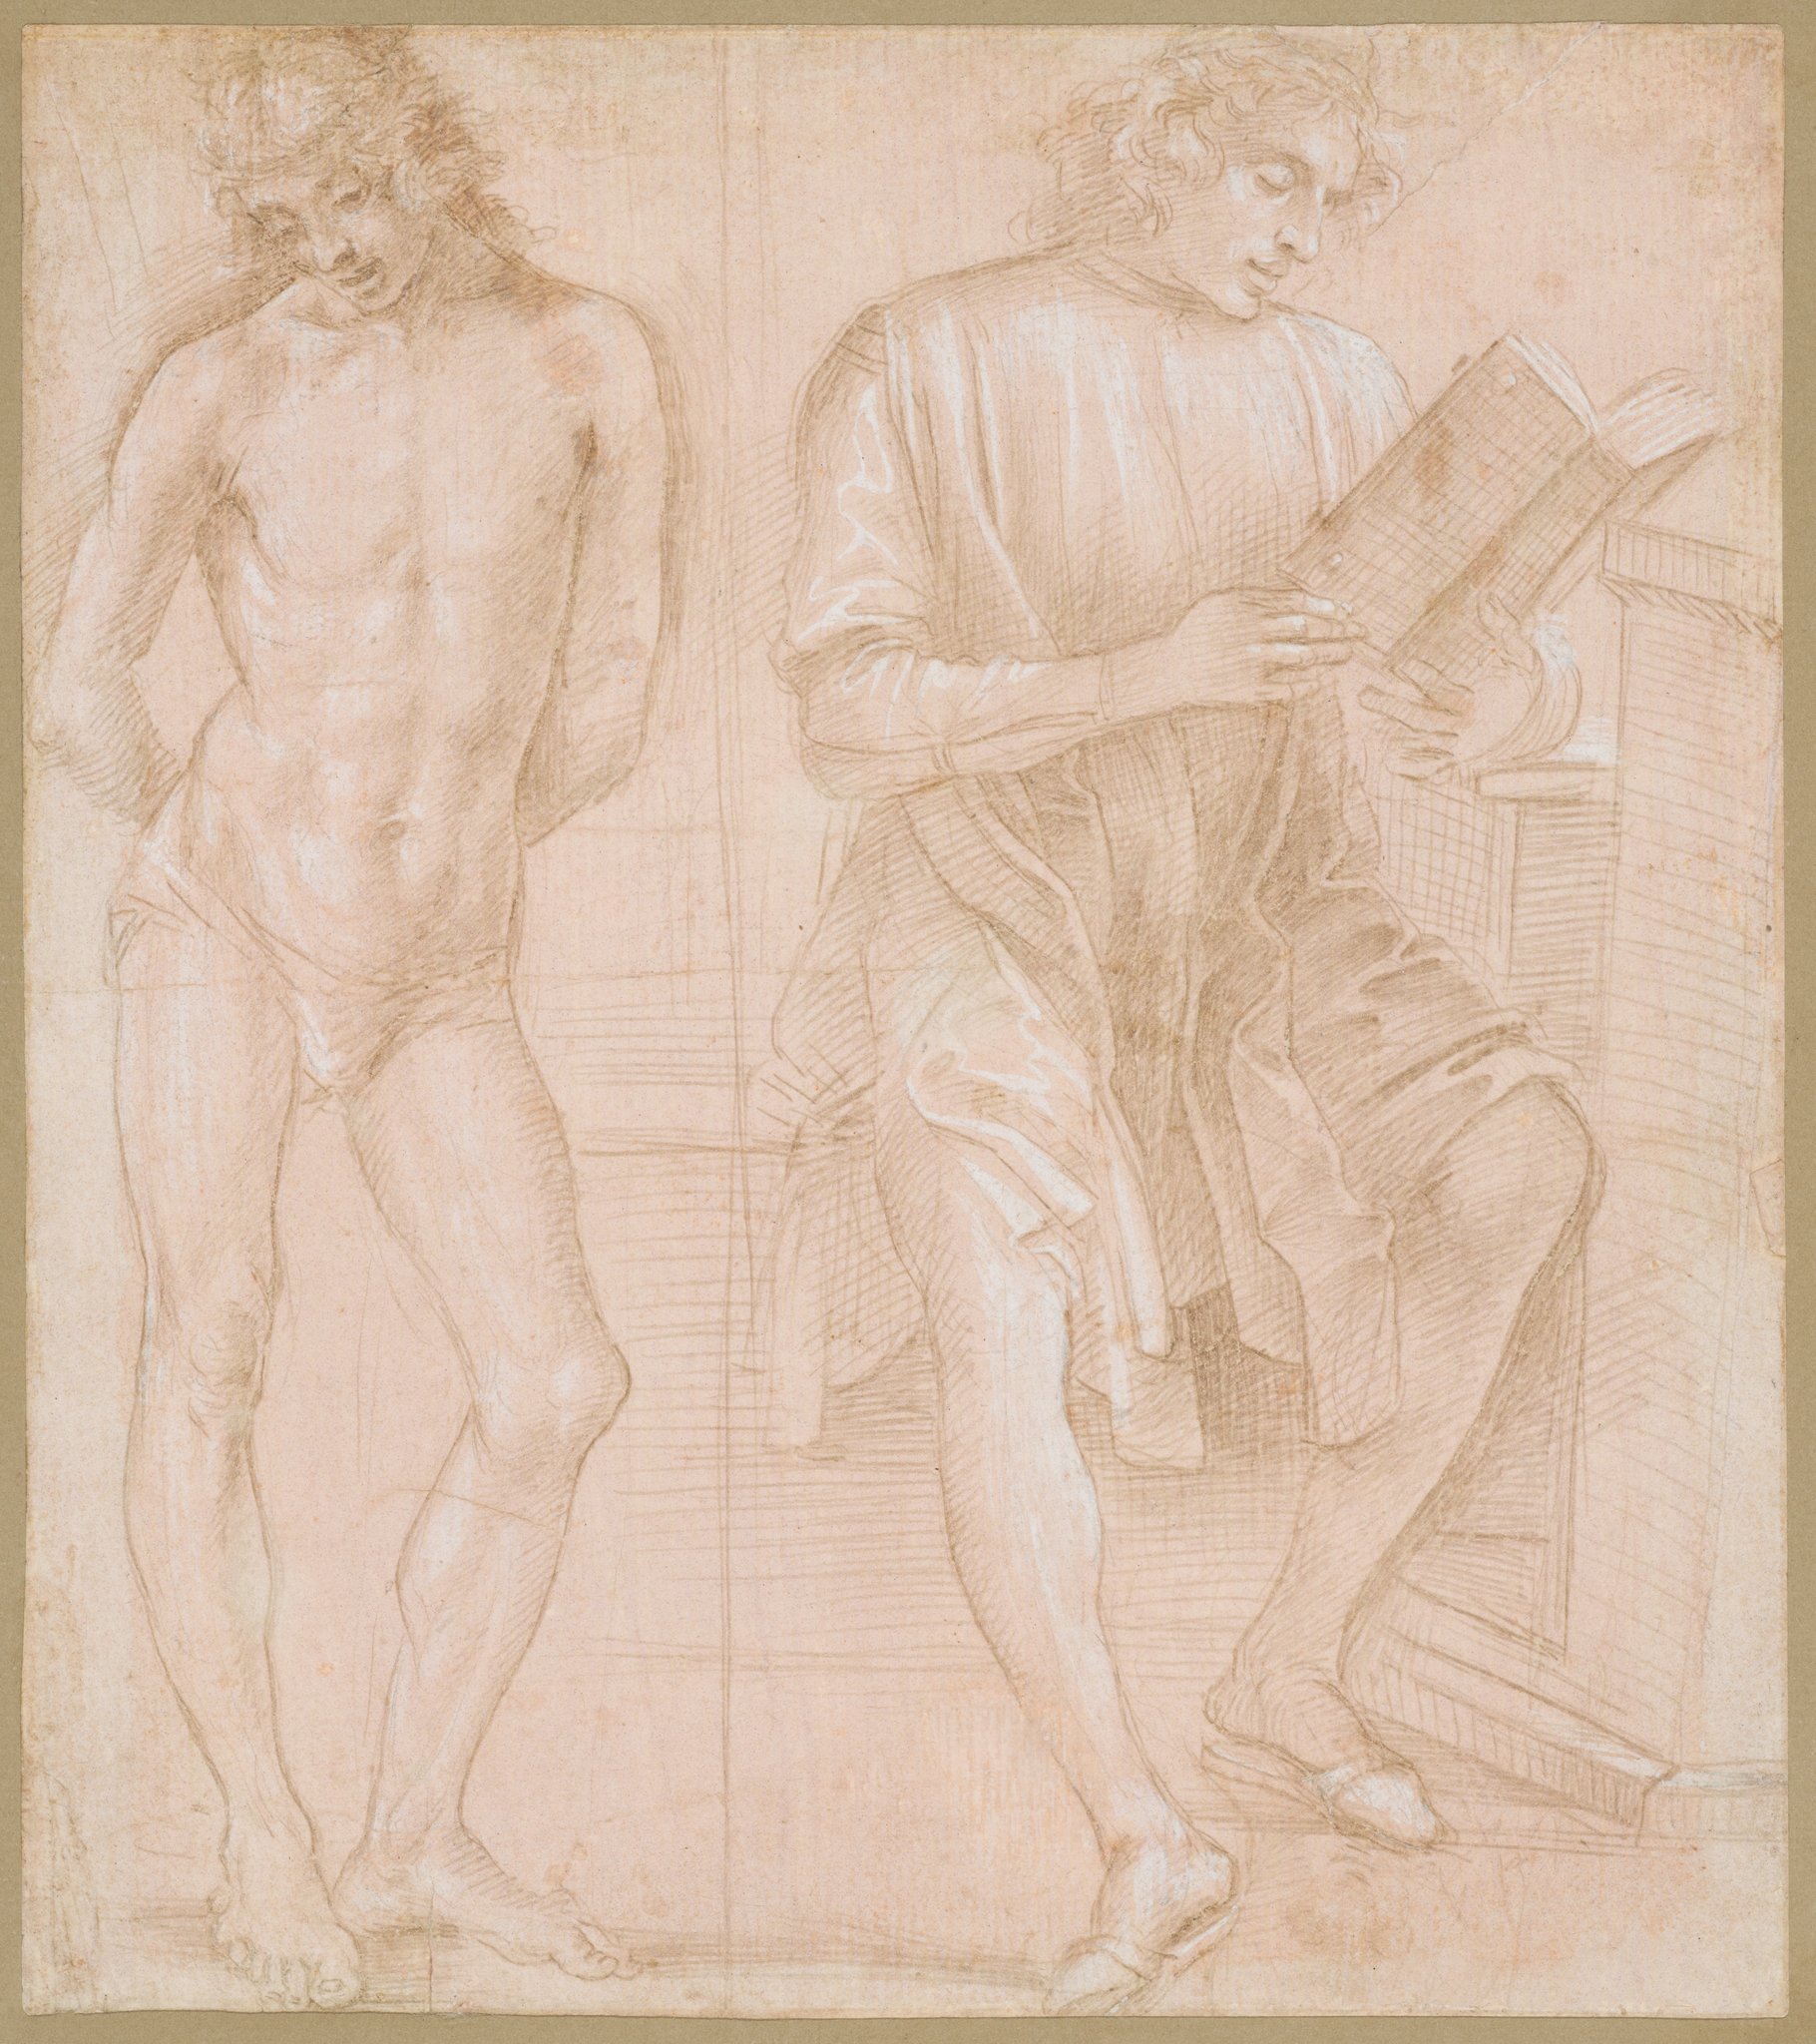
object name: drawing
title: Standing Youth with Hands Behind His Back, and a Seated Youth Reading (recto); Two Studies of Hands (verso)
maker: filippino lippi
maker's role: artist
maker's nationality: italian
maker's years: 1457-1504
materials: gouache, paper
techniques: highlighting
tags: men,reading